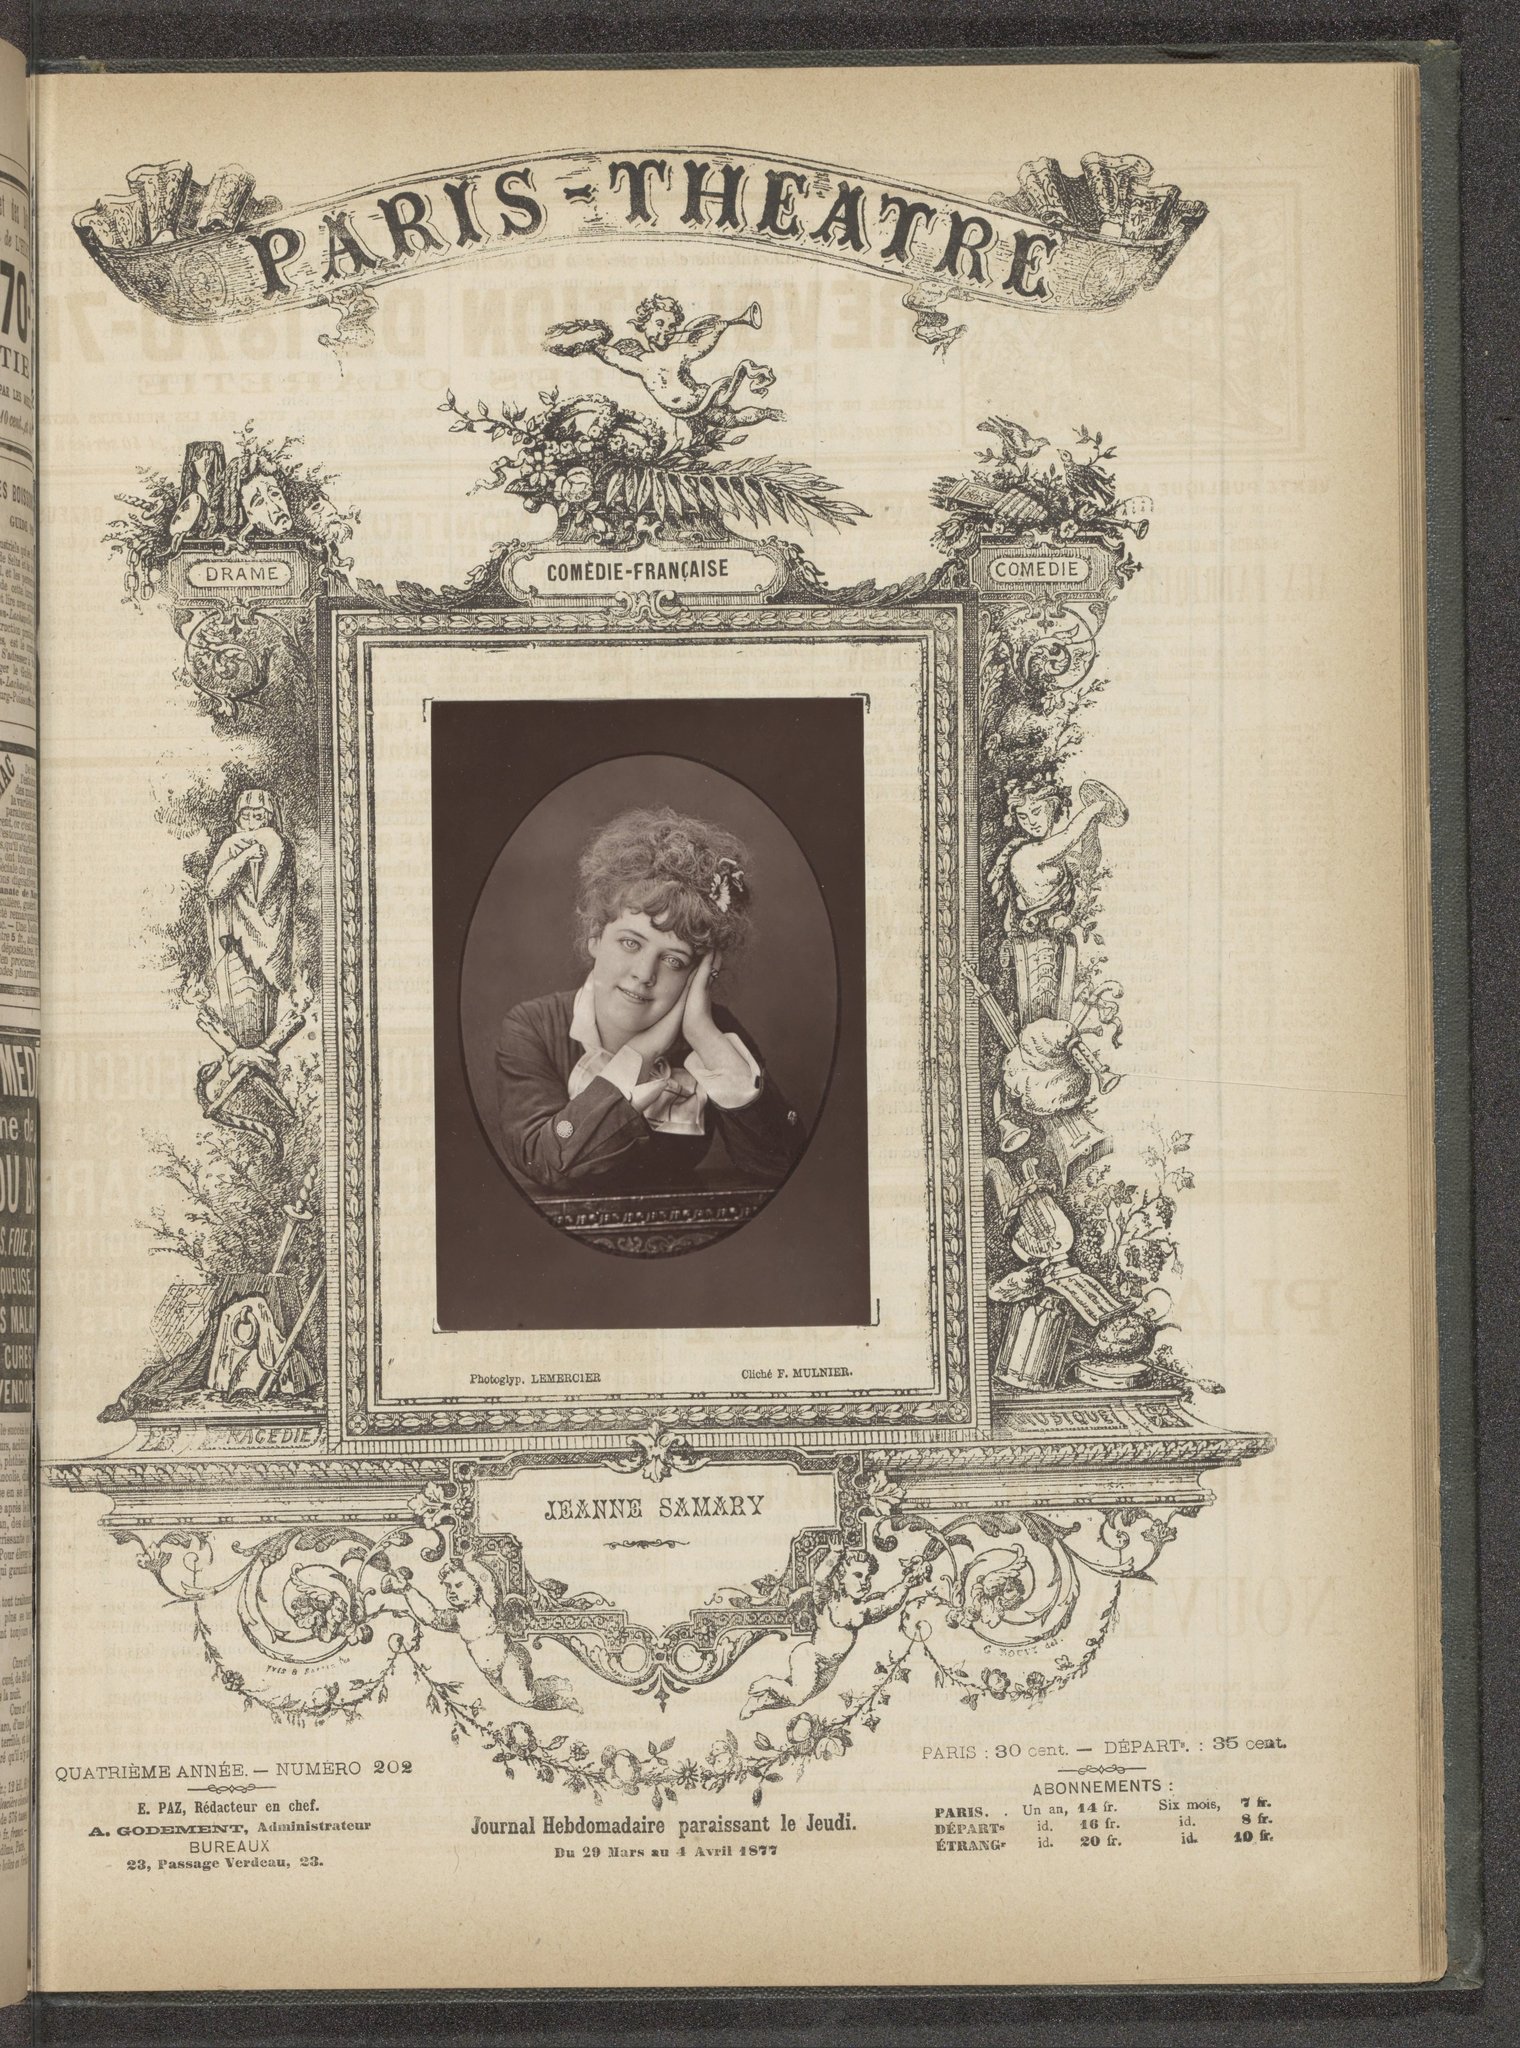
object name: photomechanical print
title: Jeanne Samary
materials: paper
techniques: woodburytype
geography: france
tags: portrait of actor, actress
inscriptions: number: ‘Numéro 202’, inscription: ‘Journal Hebdomadaire paraissant le Jeudi, Du 29 Mars au 4 Avril 1877’